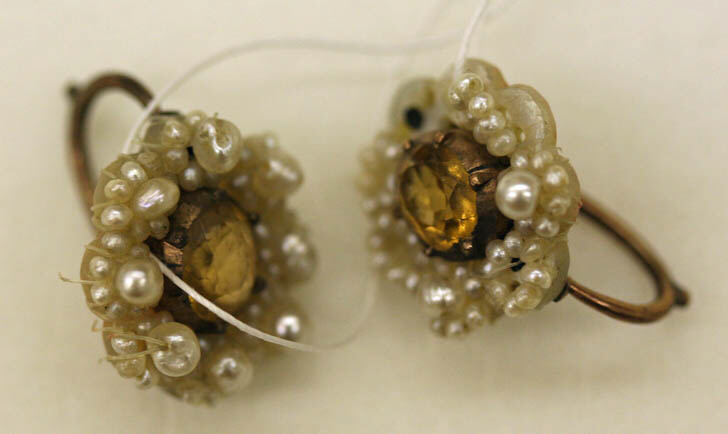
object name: earring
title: Earrings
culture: american or european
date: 1801-1900